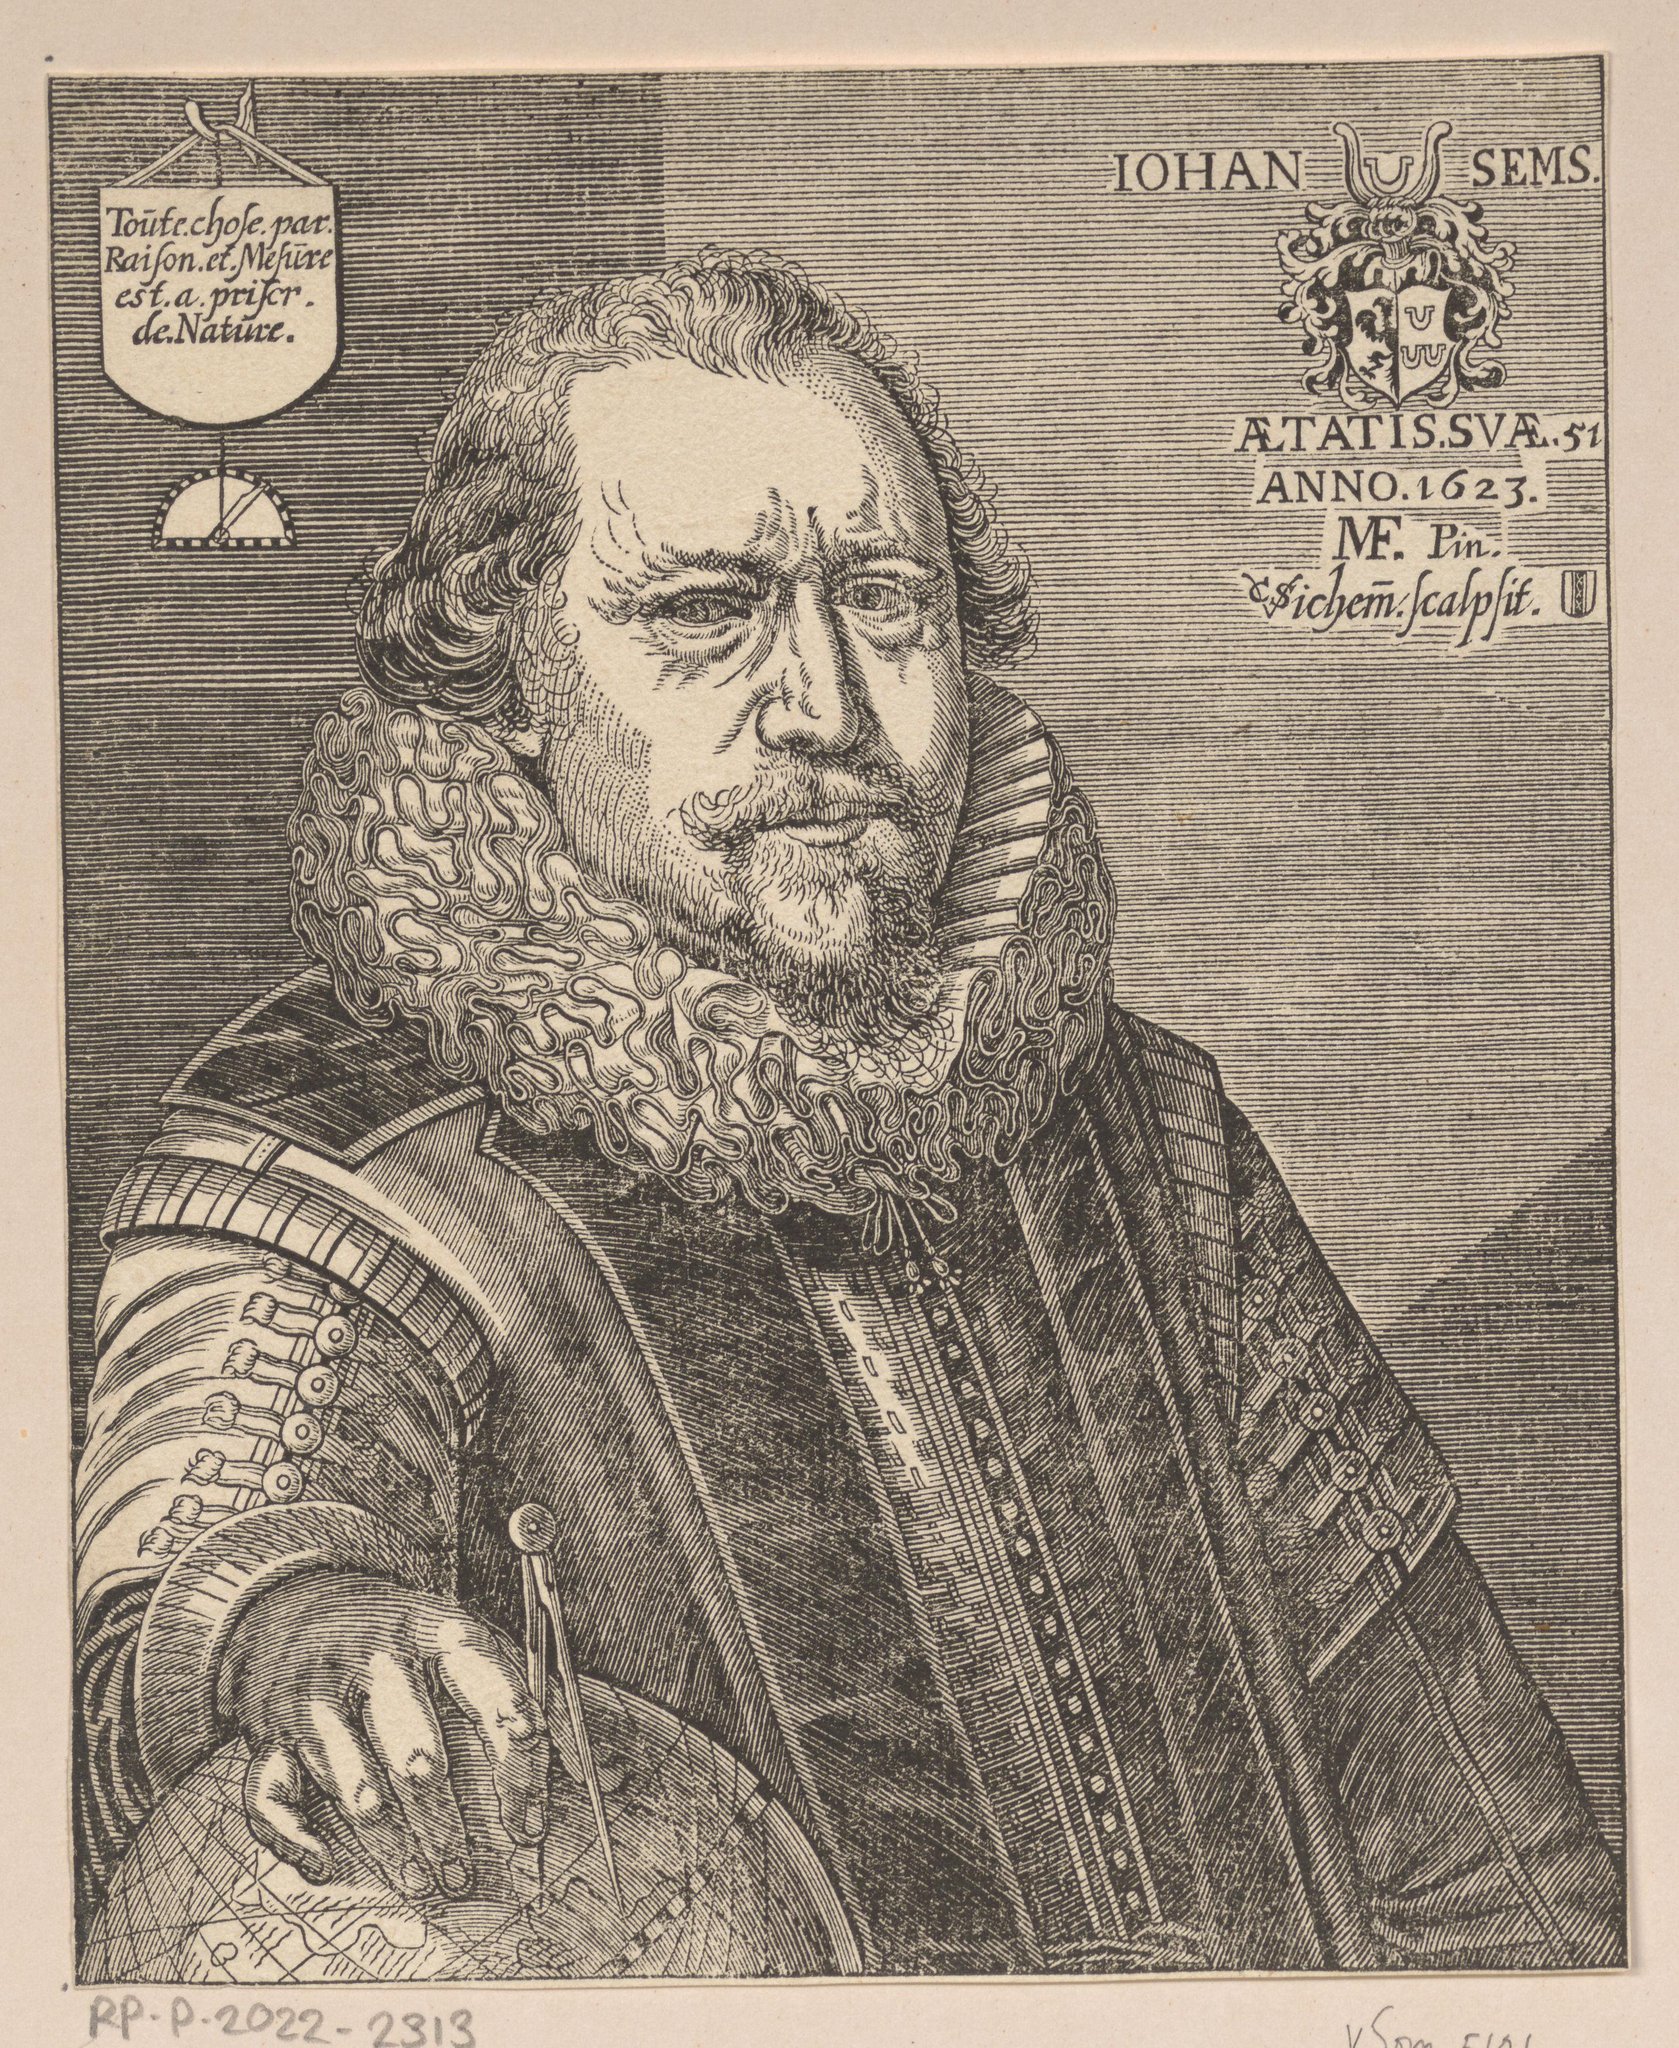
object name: print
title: Portret van Johan Sems op 51-jarige leeftijd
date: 1623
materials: paper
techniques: woodcut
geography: amsterdam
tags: johan sems, land registry, historical persons, mathematics (+ portrait of scholar, scientist)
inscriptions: collector's mark: Lugt 2228